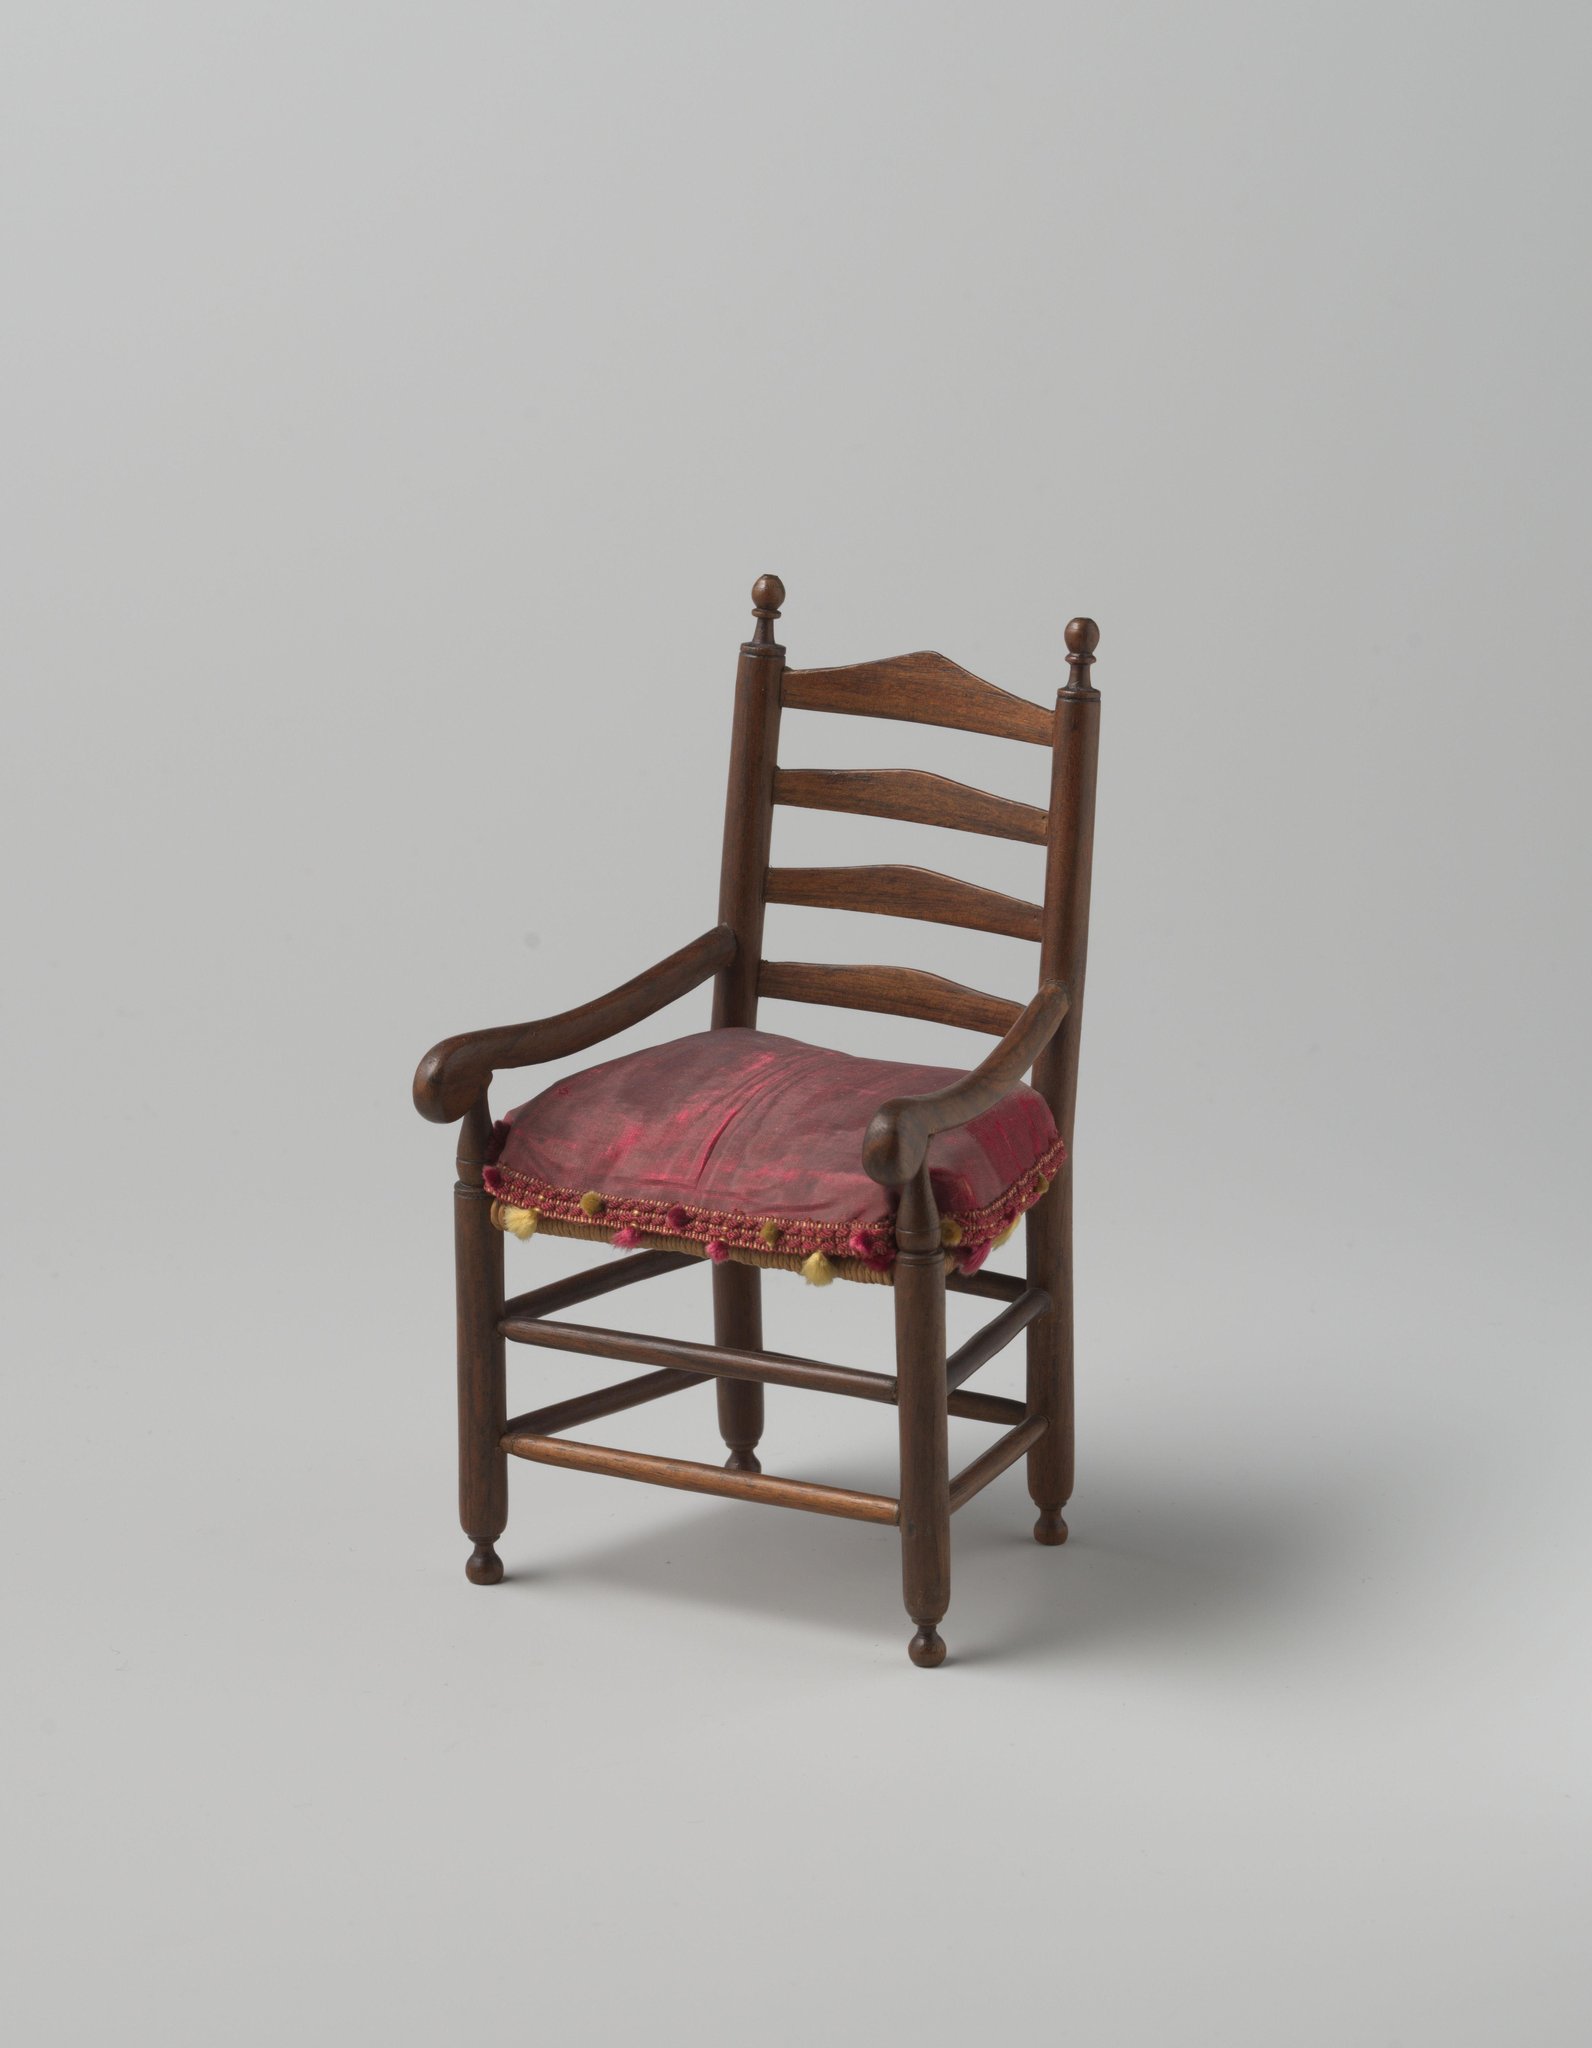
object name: armchair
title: Armstoel (model knopstoel) van notenhout met gladde, gedraaide stijlen en dwarsregels, voorpoten en achterstijlen eindigend in fijn gedraaide knoppen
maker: Anonymous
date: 1690-1710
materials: cardboard, linen, silk, fiber, wood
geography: amsterdam